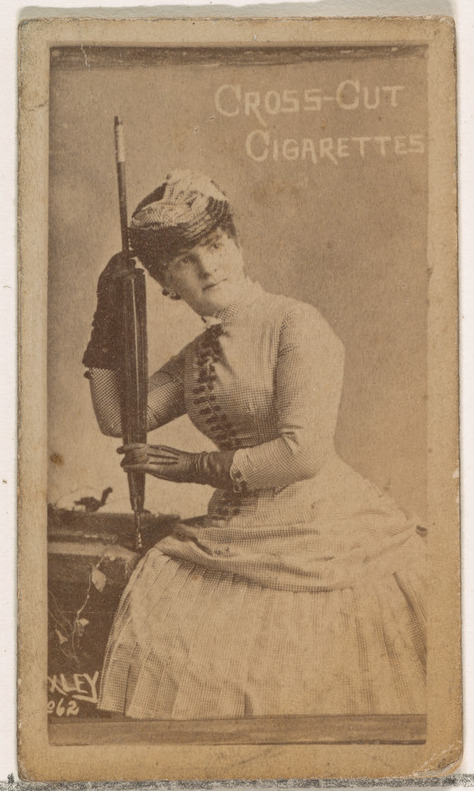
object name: print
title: Card Number 262, Annie Pixley, from the Actors and Actresses series (N145-1) issued by Duke Sons & Co. to promote Cross Cut Cigarettes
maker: w. duke, sons & co.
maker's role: publisher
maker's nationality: american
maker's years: 1870-1920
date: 1880-1889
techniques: albumen silver print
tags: portraits,women,actresses